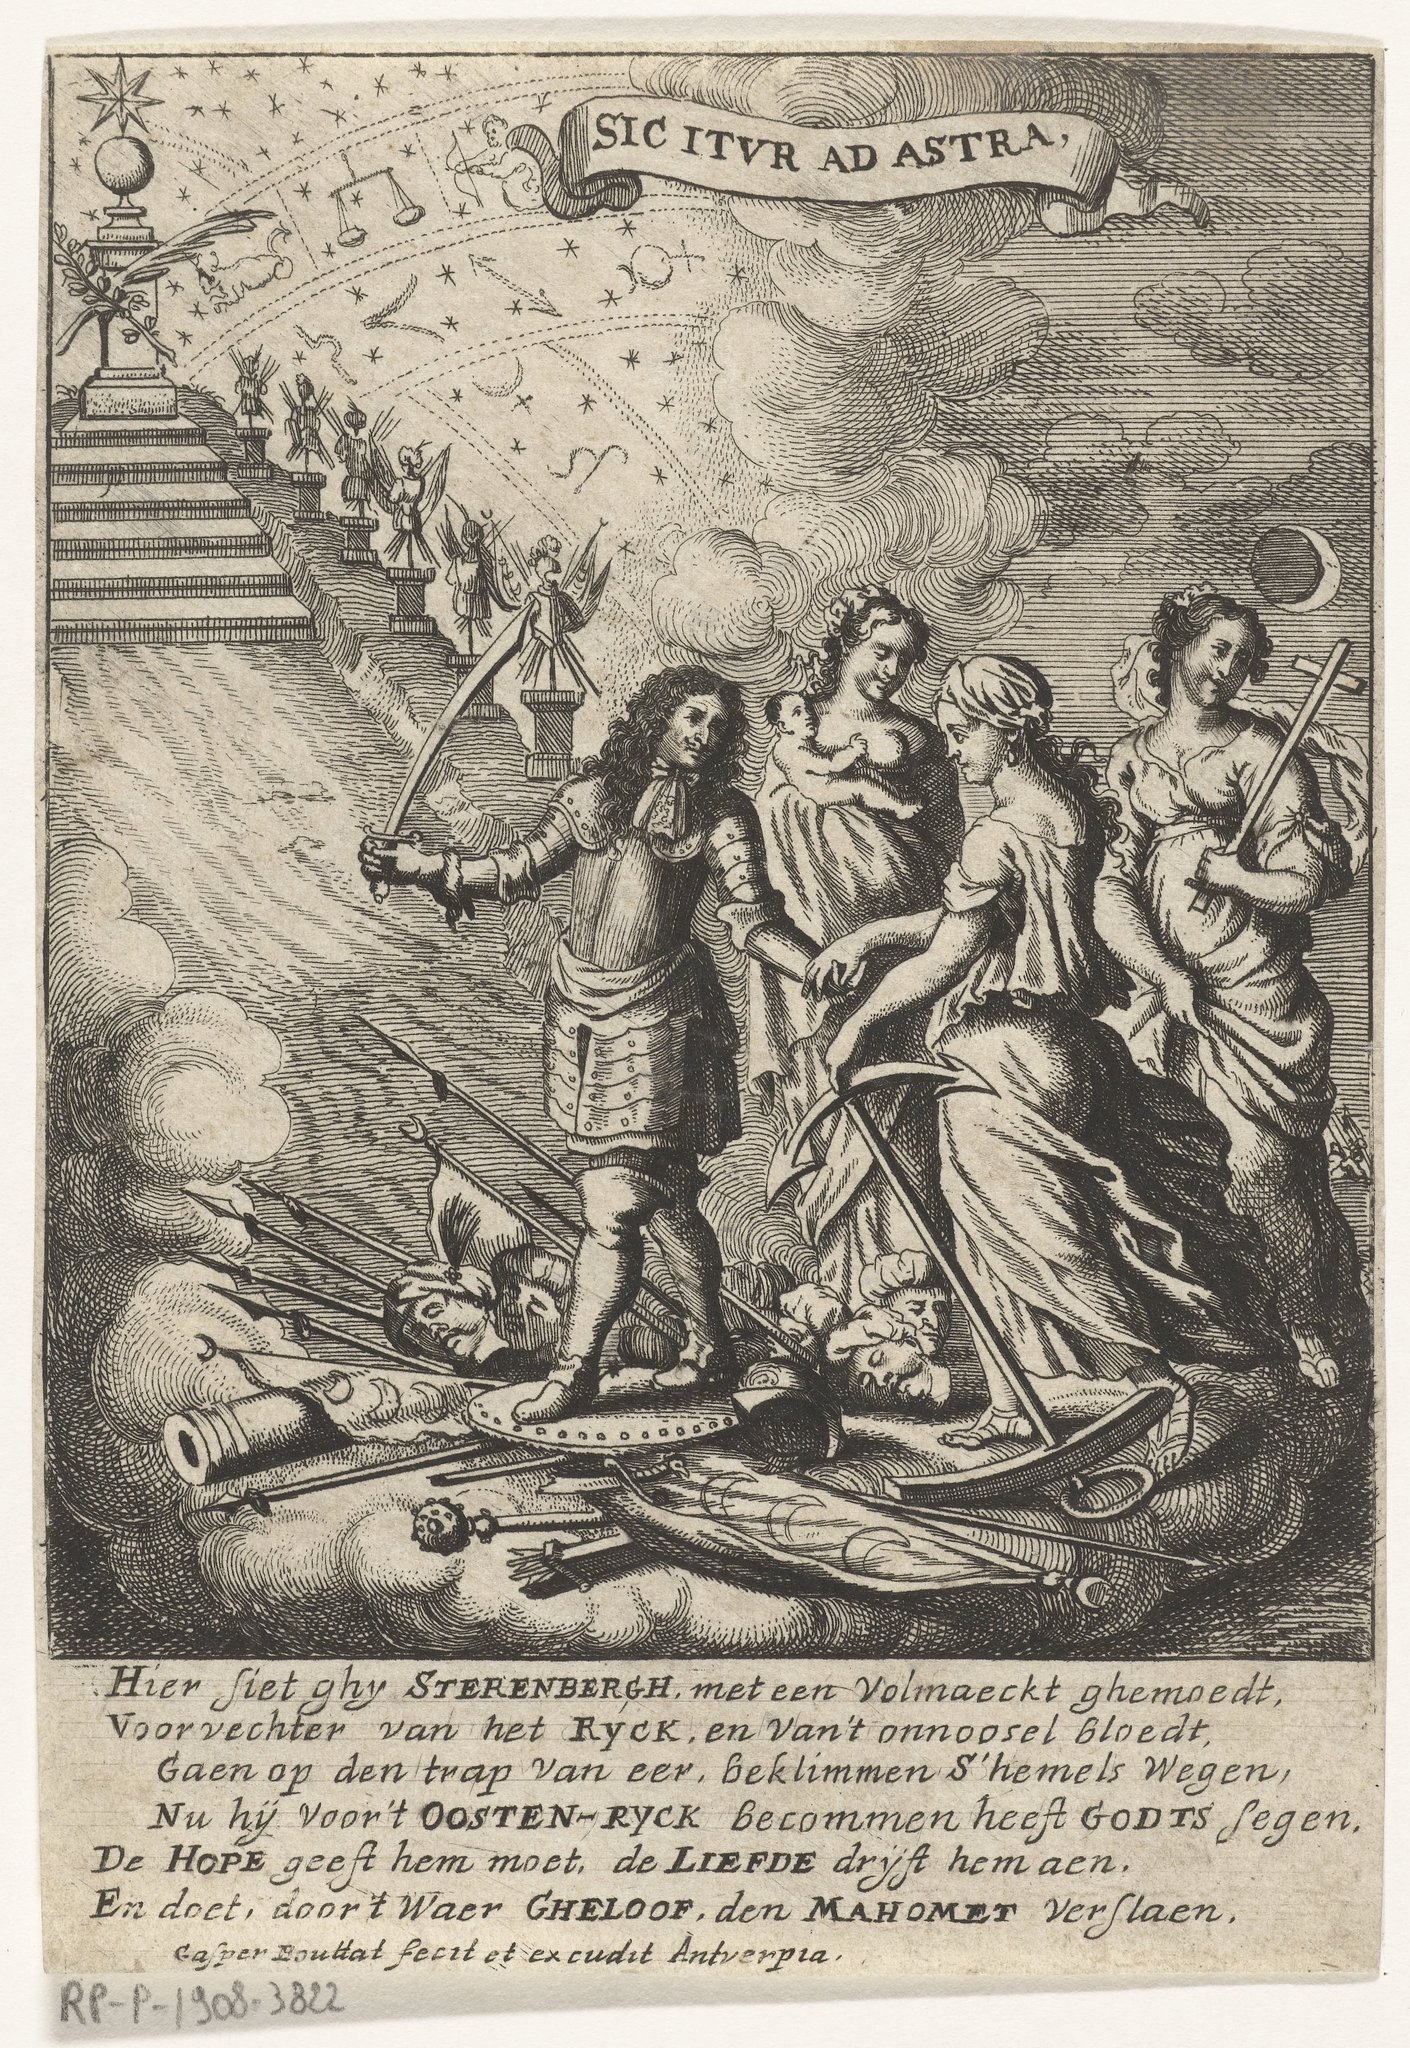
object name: print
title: Triomf van Gouverneur Starrenburg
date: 1683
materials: paper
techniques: etching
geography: antwerp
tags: asiatic races and peoples: turks, the three theological virtues, armour, head of a beheaded person, the heavens (celestial bodies)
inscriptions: collector's mark: Lugt 2228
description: Gouverneur Starrenburg staat centraal in de prent. Hij draagt een harnas en staat op de wapens en vaandels van overwonnen Ottomaanse strijders. Naast hem op de grond liggen de afgekapte hoofden van enkele van deze Ottomaanse soldaten. Hij wordt door Hoop, Geloof en Liefde vergezeld op de trap van Eer richting de hemelberg, waar een triomfboog op hem wacht. Een cartouche bovenaan de prent heeft een Latijns devies. De prent heeft een nederlands onderschrift: 'Hier siet ghy Sterenbergh met een volmaeckt ghemoedt. Voorvechter van het Ryck, en van't onnoosel Bloedt. Gaen op den trap van eer, beklimmen S'hemels wegen, nu hij voor Oosten-ryck becommen heeft Godts segen. De Hope geeft hem moet, de Liefde drijft hem aen. En doet doot't waer gheloof den Mahomet verslaen'.